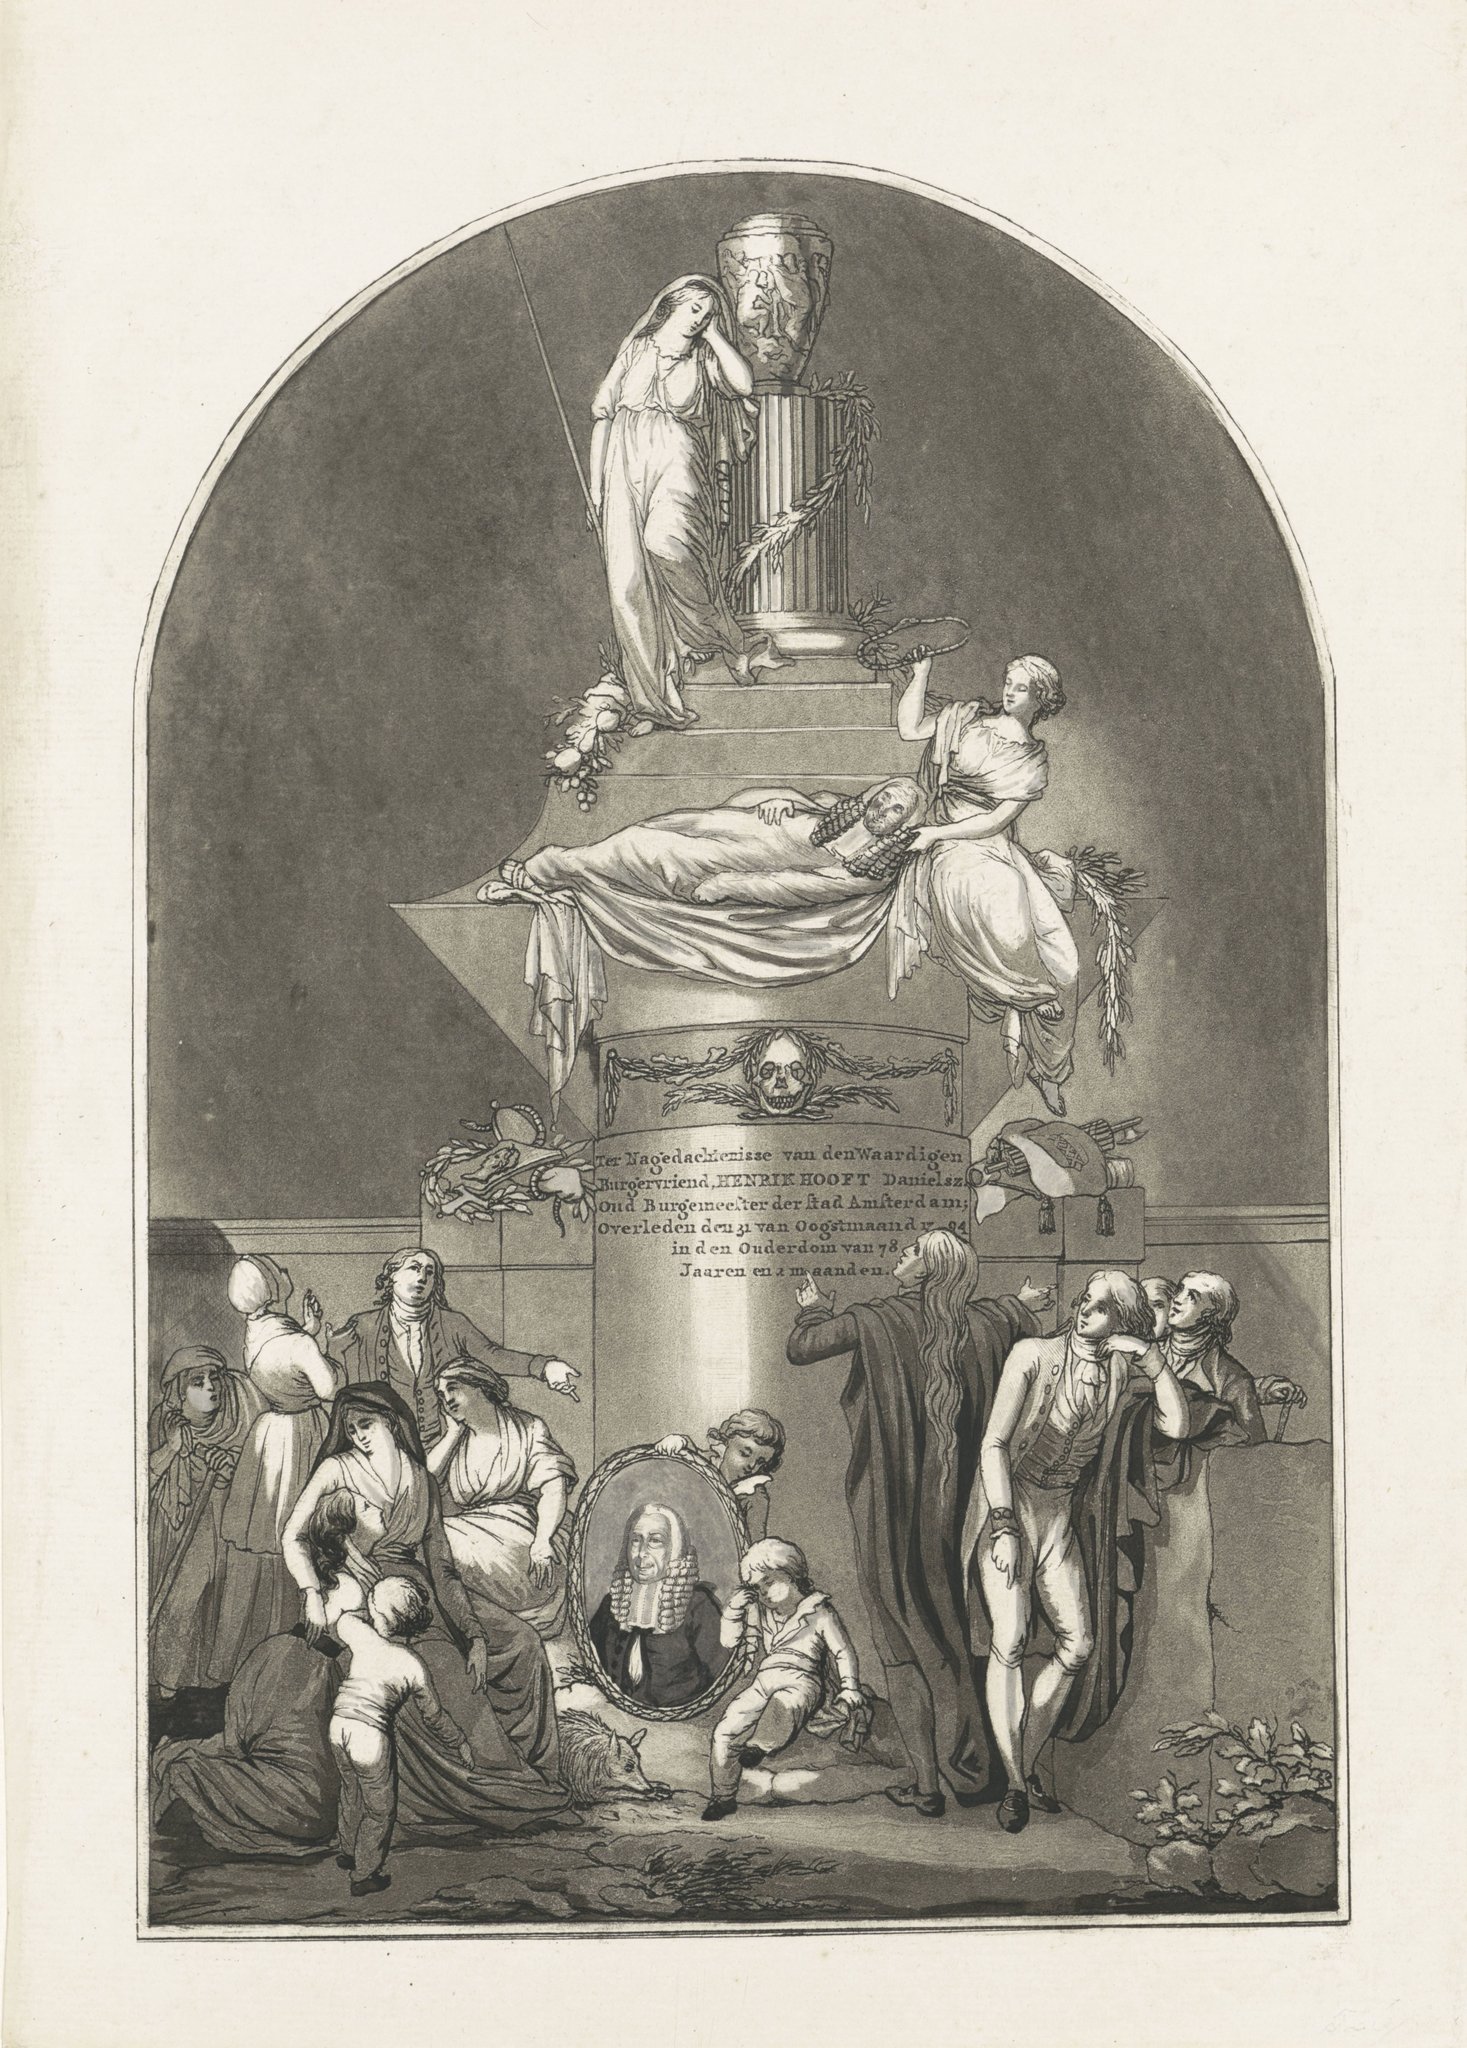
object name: print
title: Allegorisch grafmonument voor Hendrik Danielsz. Hooft, 1794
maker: Anonymous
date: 1794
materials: paper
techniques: aquatint, brush, etching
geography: northern netherlands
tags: amsterdam, mayor, hendrik danielsz. hooft, grave, tomb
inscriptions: collector's mark: Lugt 2228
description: Allegorisch zuilvormig grafmonument voor Hendrik Danielsz. Hooft, oud-burgemeester van Amsterdam, overleden op 31 augustus 1794. Het lichaam van Hooft ondersteund door een allegorische vrouwenfiguur. Aan de voet van de zuil treurende burgers en twee kinderen met een portret van de overledene. Op de zuil een grafschrift in zes regels.